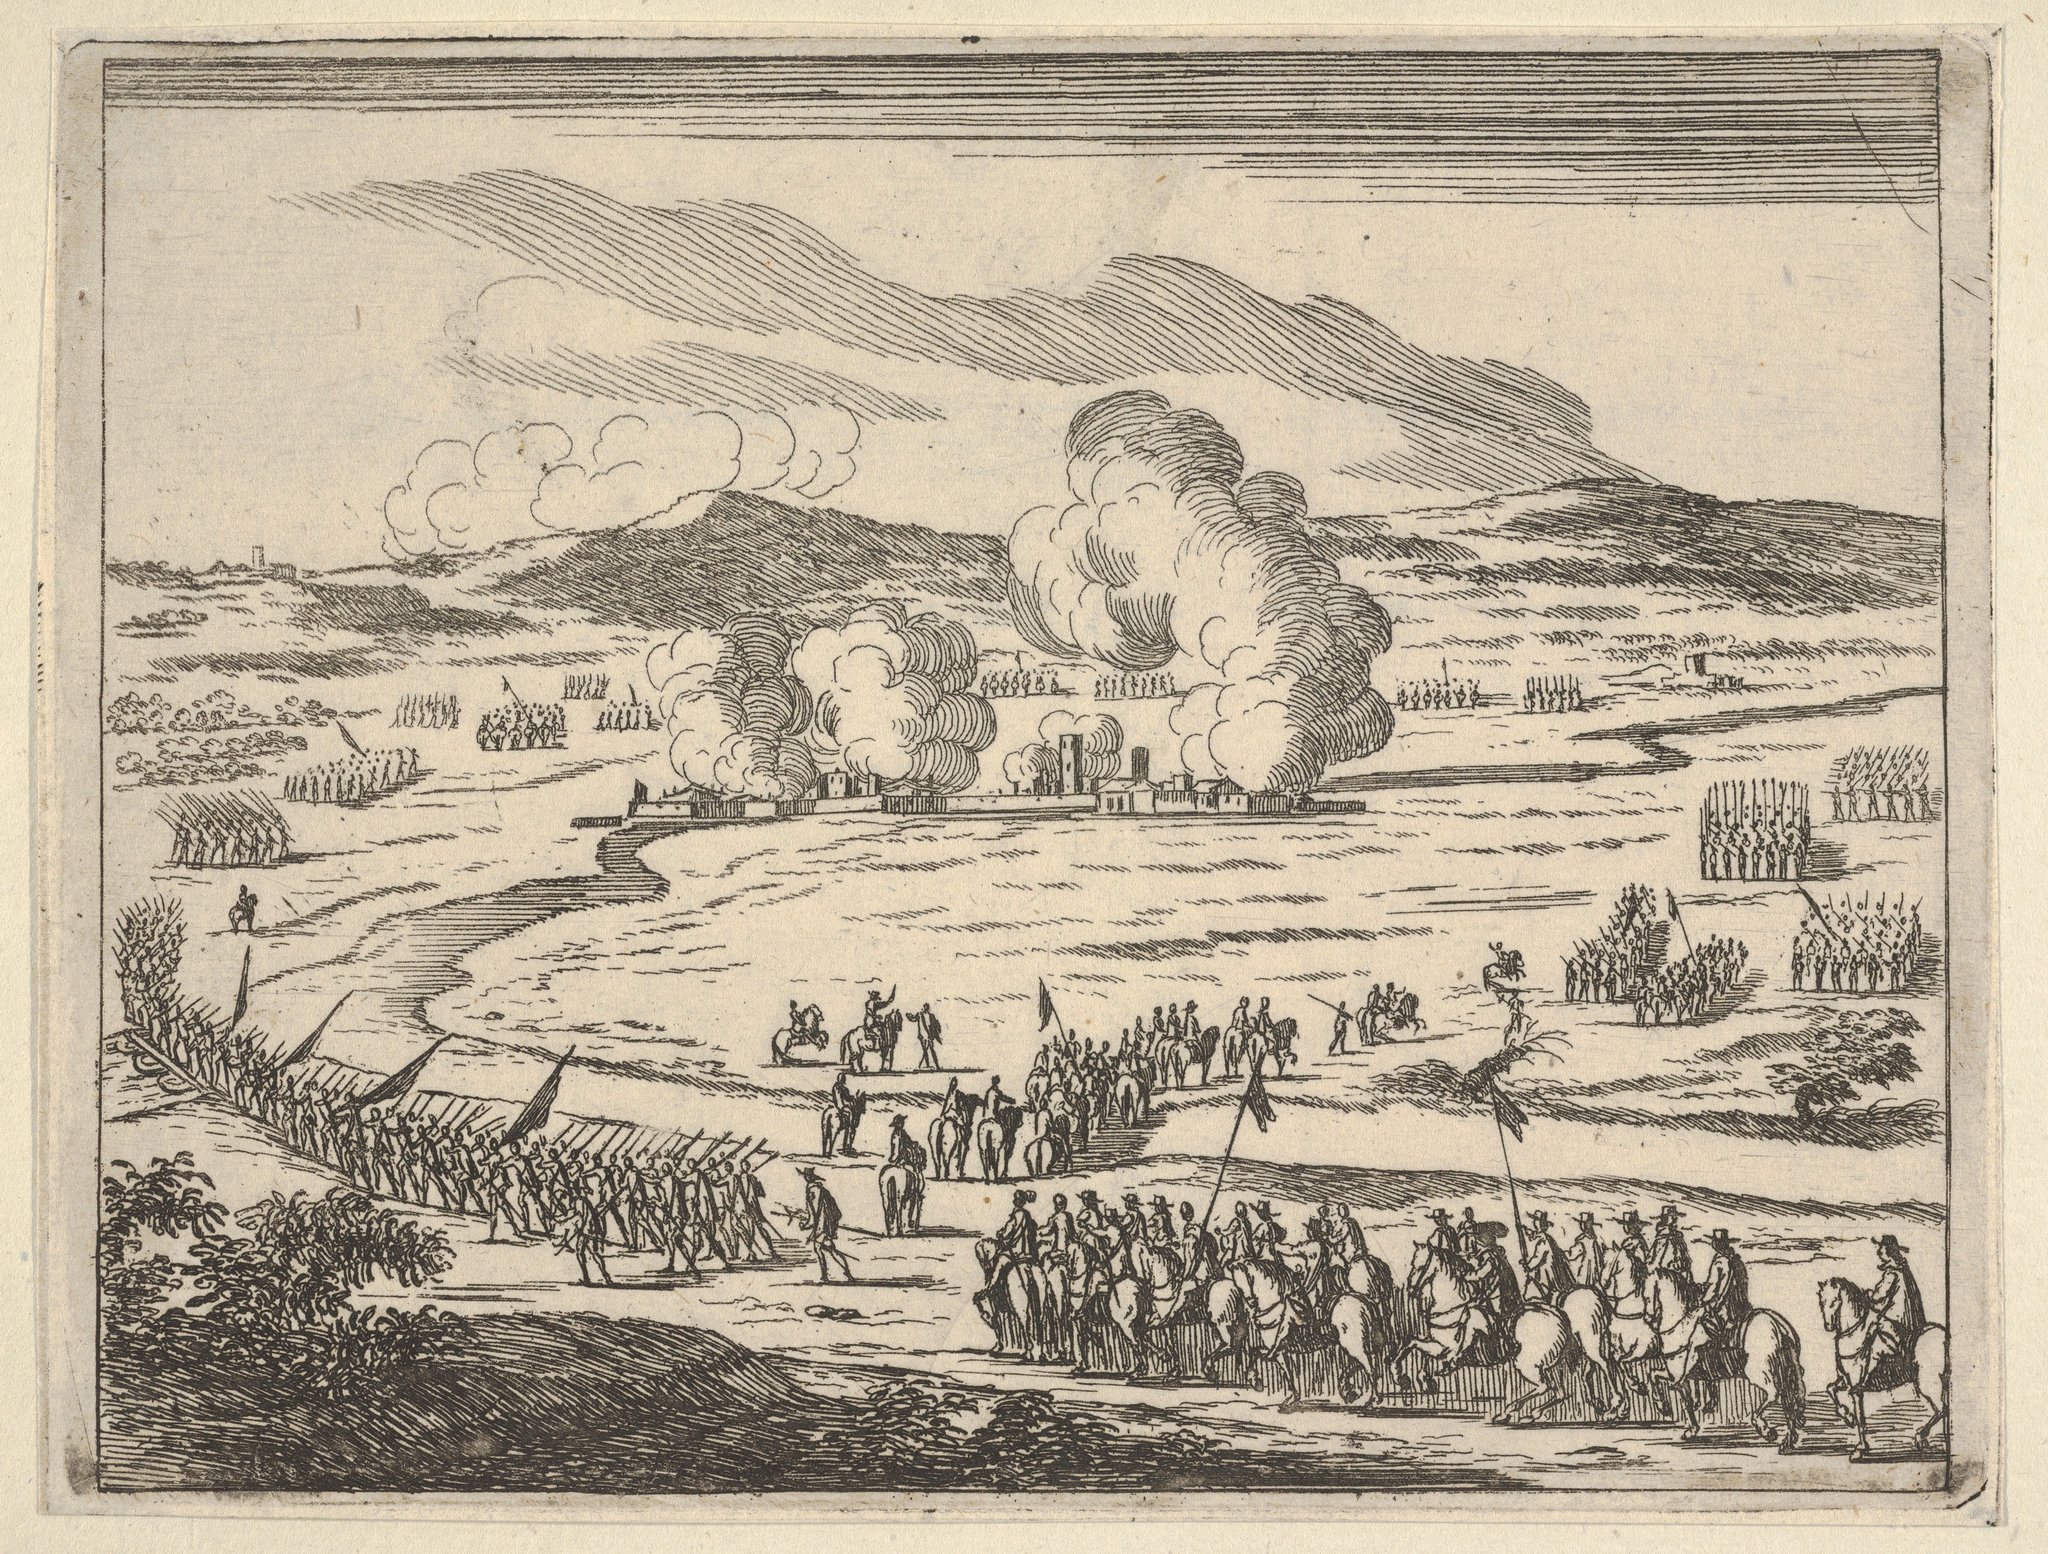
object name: print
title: The Seige of Alessandria Begins, from "L'Idea di un Principe ed Eroe Cristiano in Francesco I d'Este, di Modena e Reggio Duca VIII [...]"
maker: bartolomeo fenice (fénis)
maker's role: artist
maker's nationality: italian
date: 1659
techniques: etching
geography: italy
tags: battles,soldiers,horses,crowd,flags